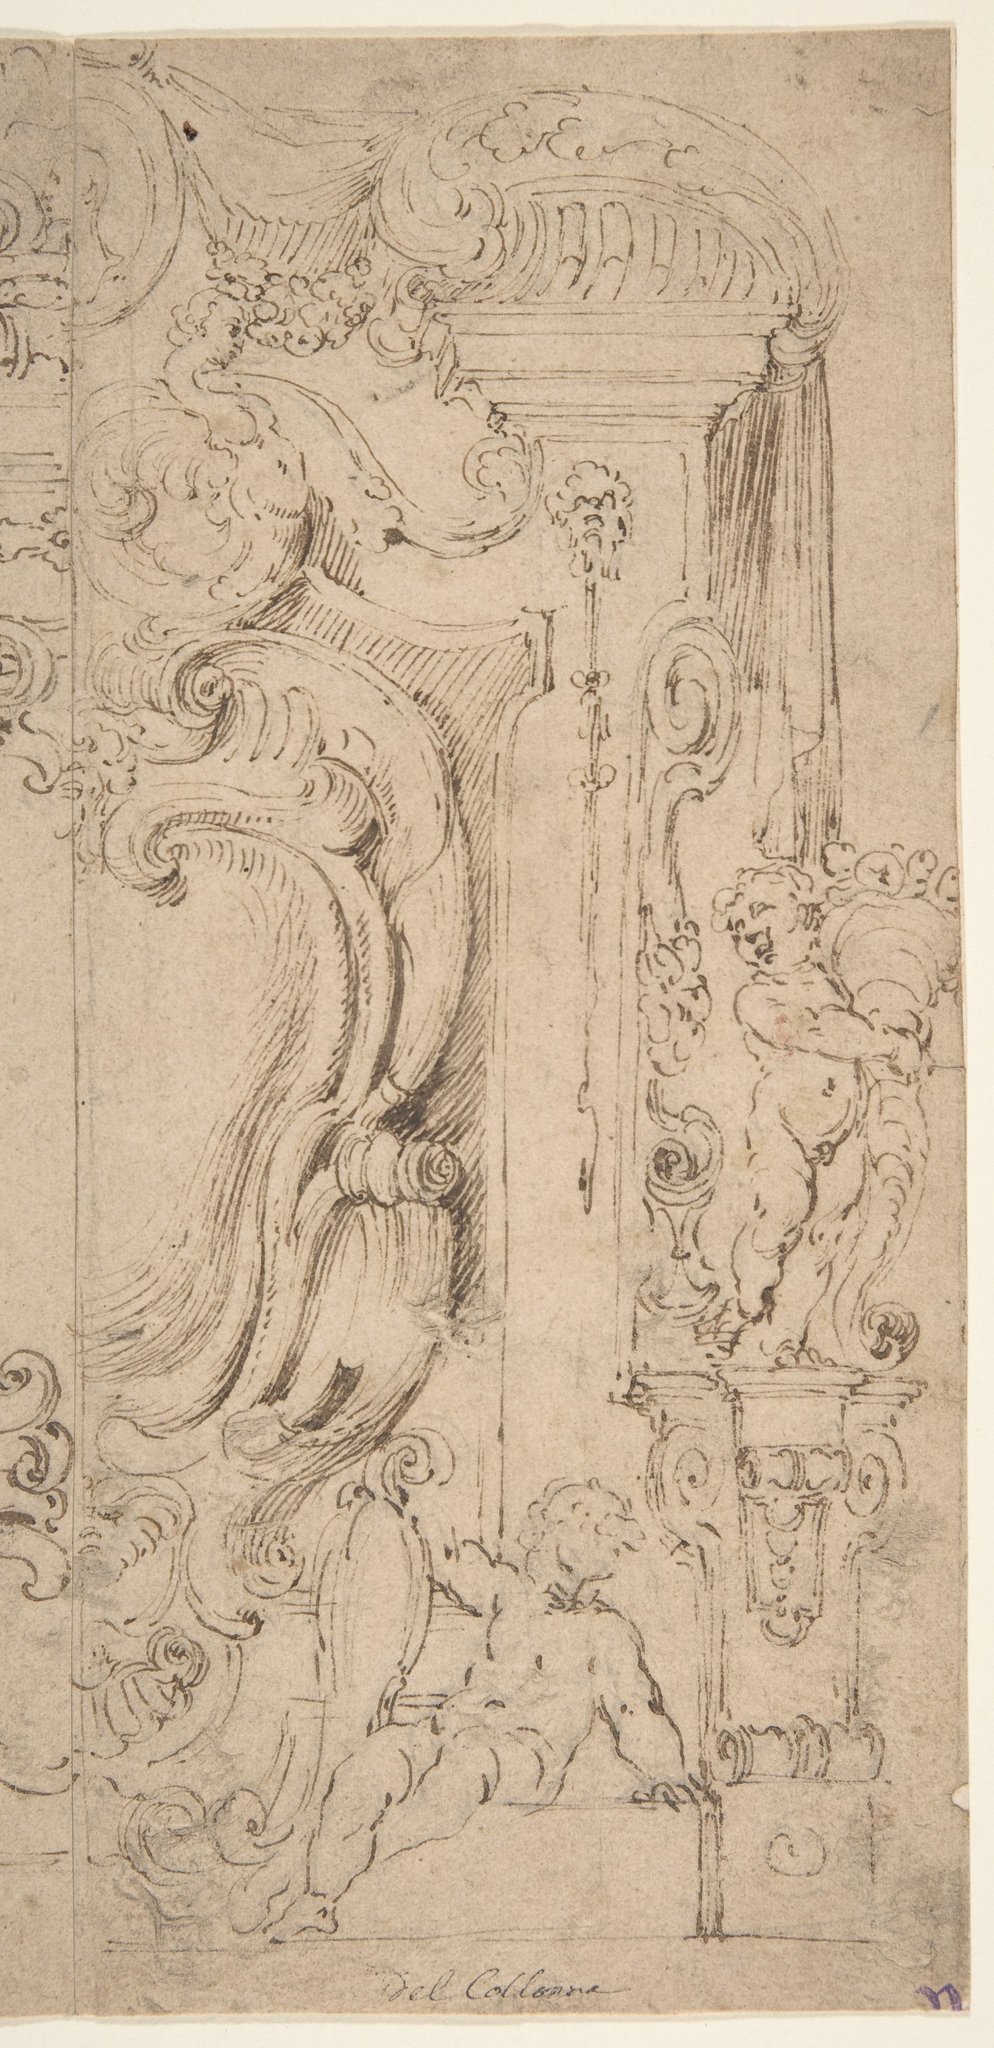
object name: drawing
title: Right and Part of the Left Half of a Design for a Cartouche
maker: michelangelo colonna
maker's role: artist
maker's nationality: italian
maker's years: 1604-1687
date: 1624-1687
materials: chalk, ink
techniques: pen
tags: cartouches